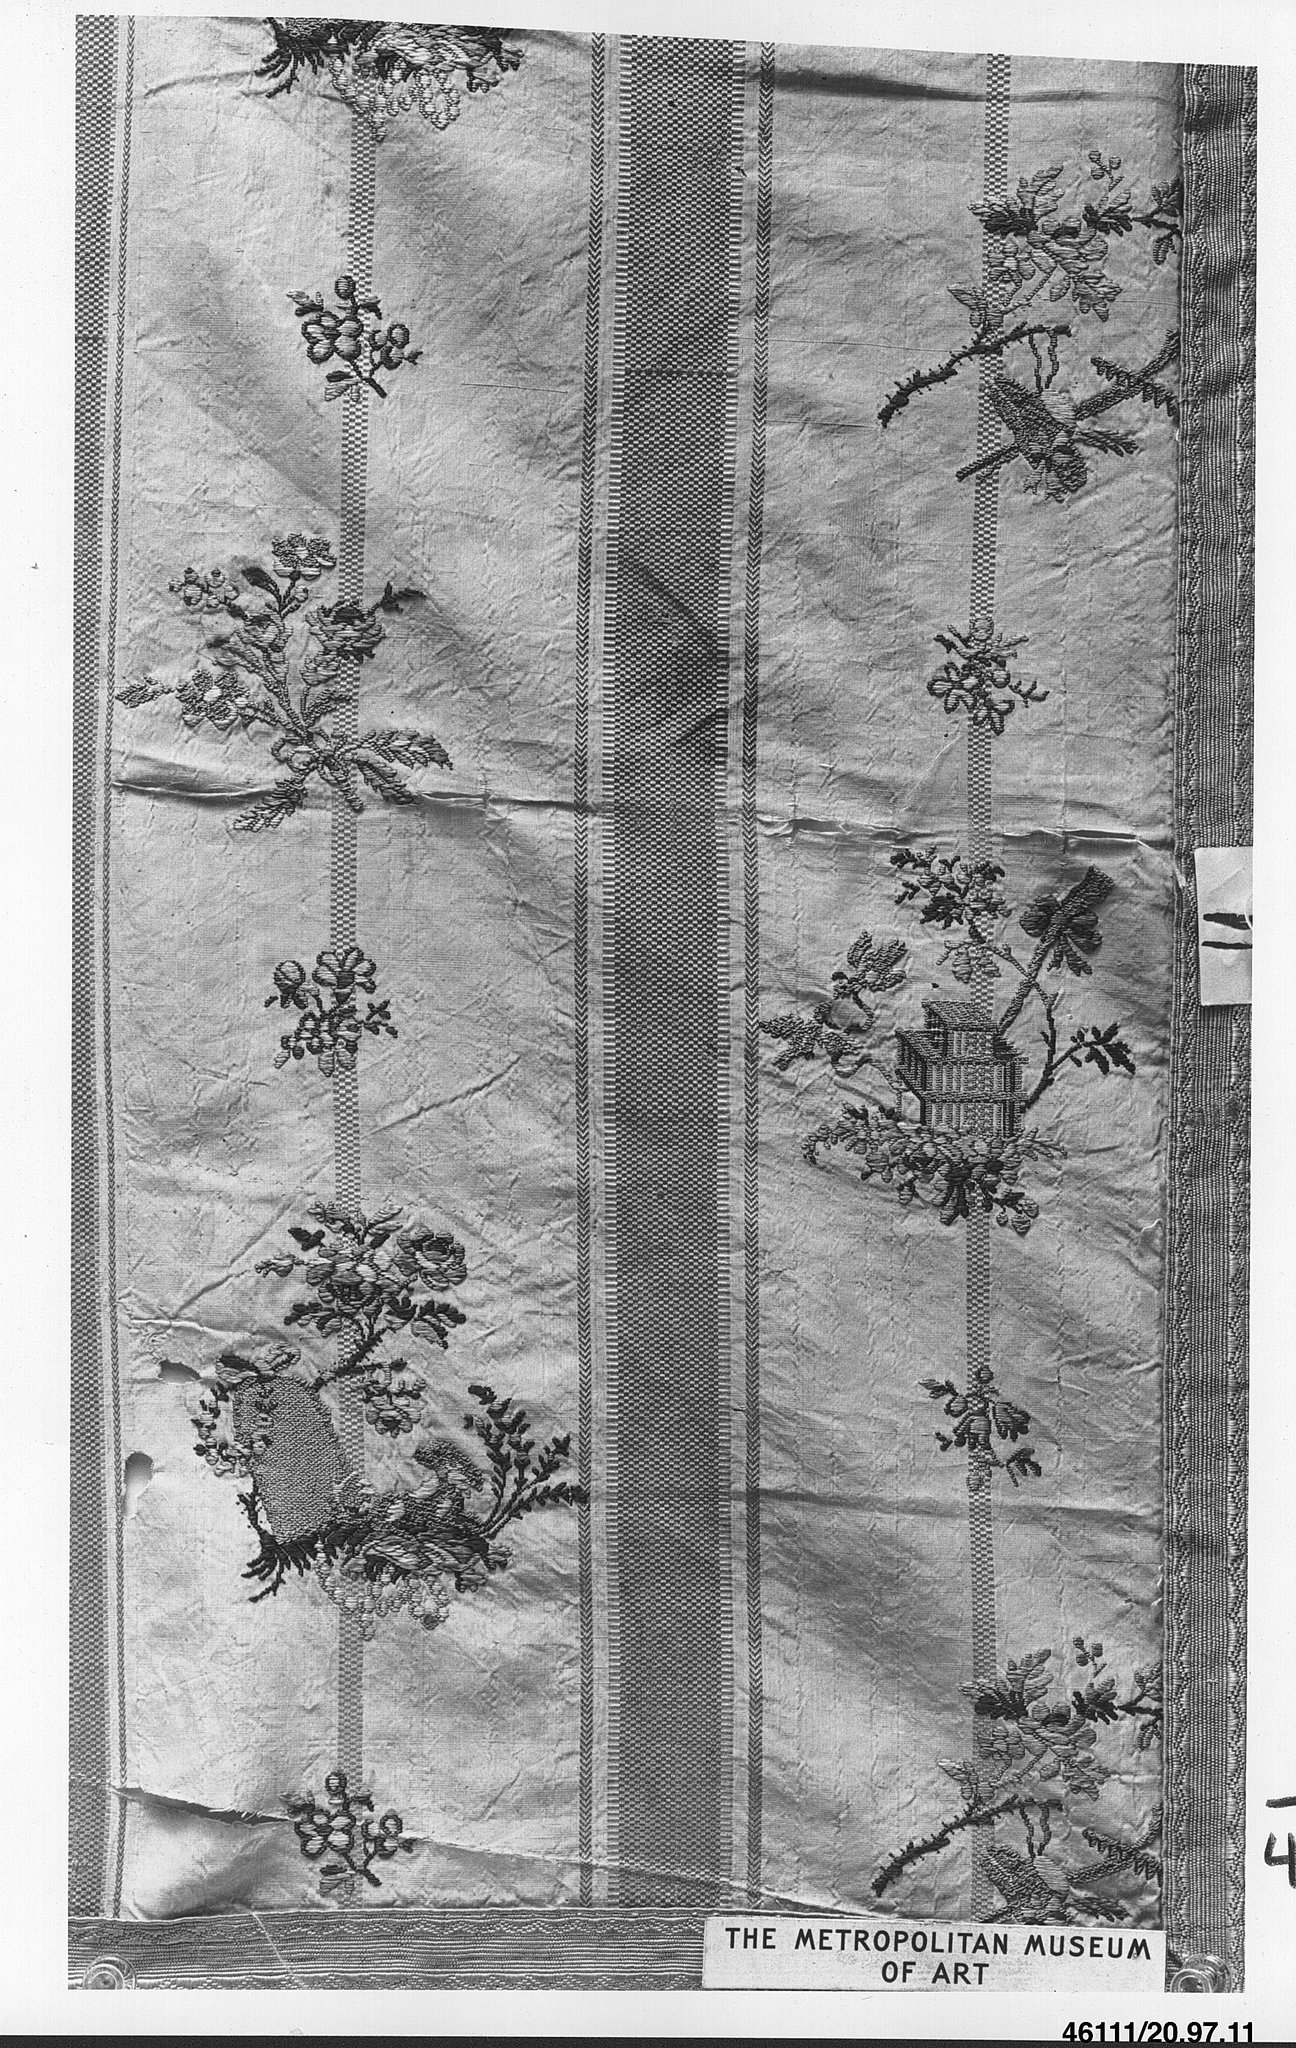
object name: piece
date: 1774-1792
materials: silk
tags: flowers,leaves